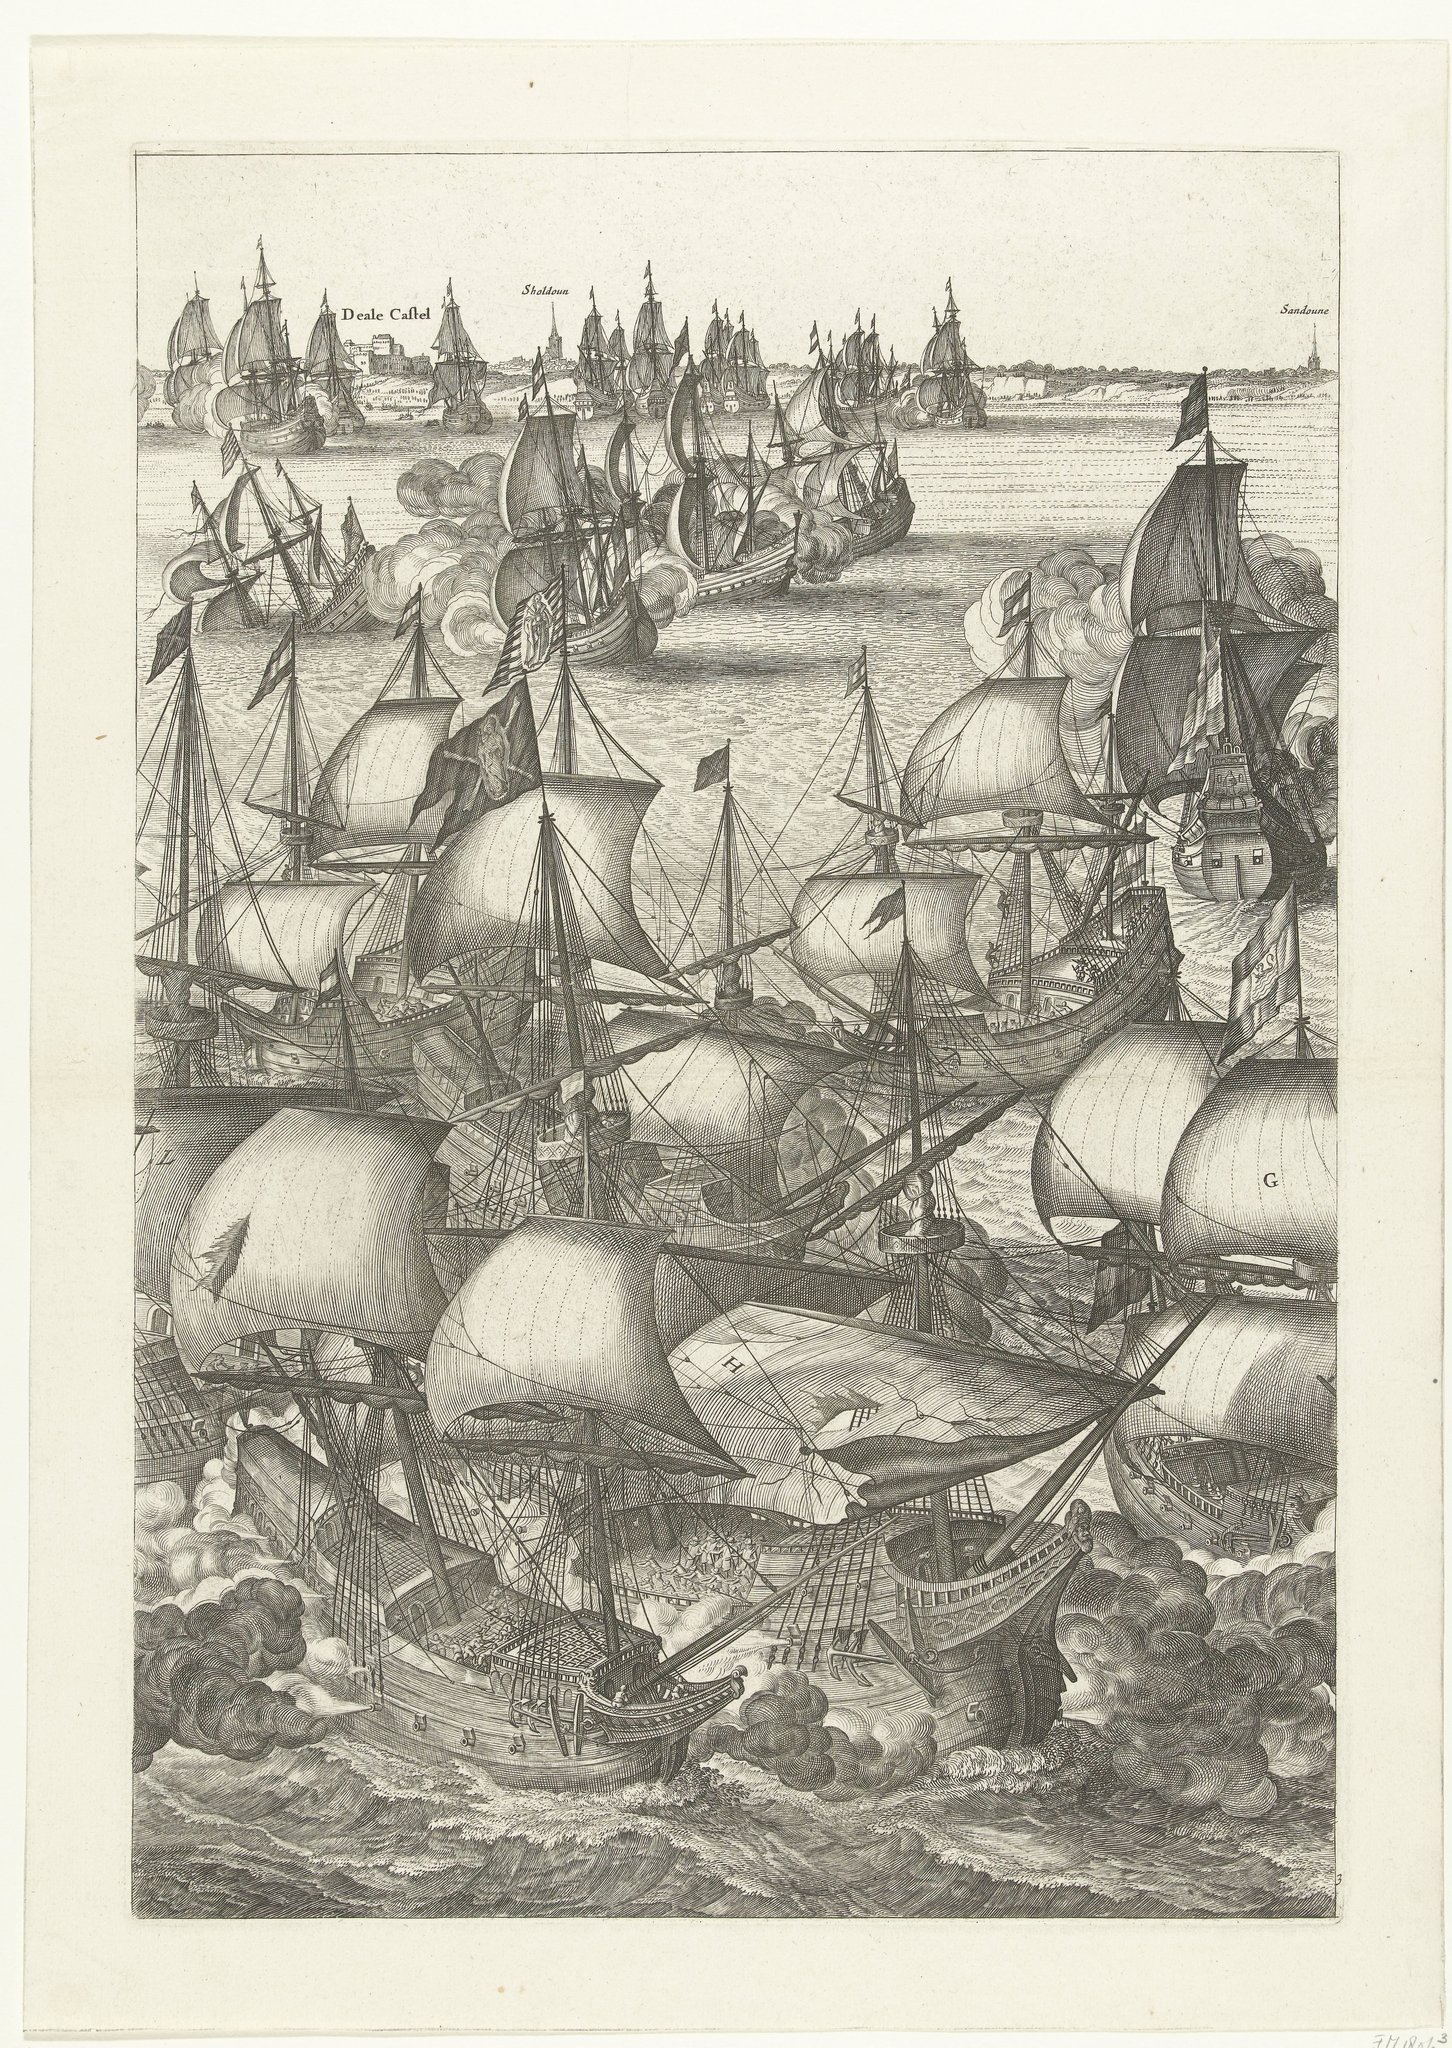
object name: print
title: Pugna navalis qua Hispanos vicere in Duins Angliae Belgae Foederati Ao. MDCXXXIX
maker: claes jansz. visscher (ii)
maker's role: draughtsman, print maker, publisher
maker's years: 1586-1652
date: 1640-1643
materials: paper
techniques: engraving, etching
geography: amsterdam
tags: maarten harpertszoon tromp, battle (+ naval force), battle of the downs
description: Grote voorstelling van de zeeslag bij Duins tussen de Spaanse vloot onder bevel van Antonio de Oquendo en de Staatse vloot onder Maarten Harpertsz. Tromp, 21 oktober 1639. Blad 3: gevechten op zee, op de achtergrond de Engelse kust bij Deal. Ongemonteerde ensemble bestaande uit 7 genummerde platen, de zwarte stroken met de titel en tekstblad met de beschrijving.